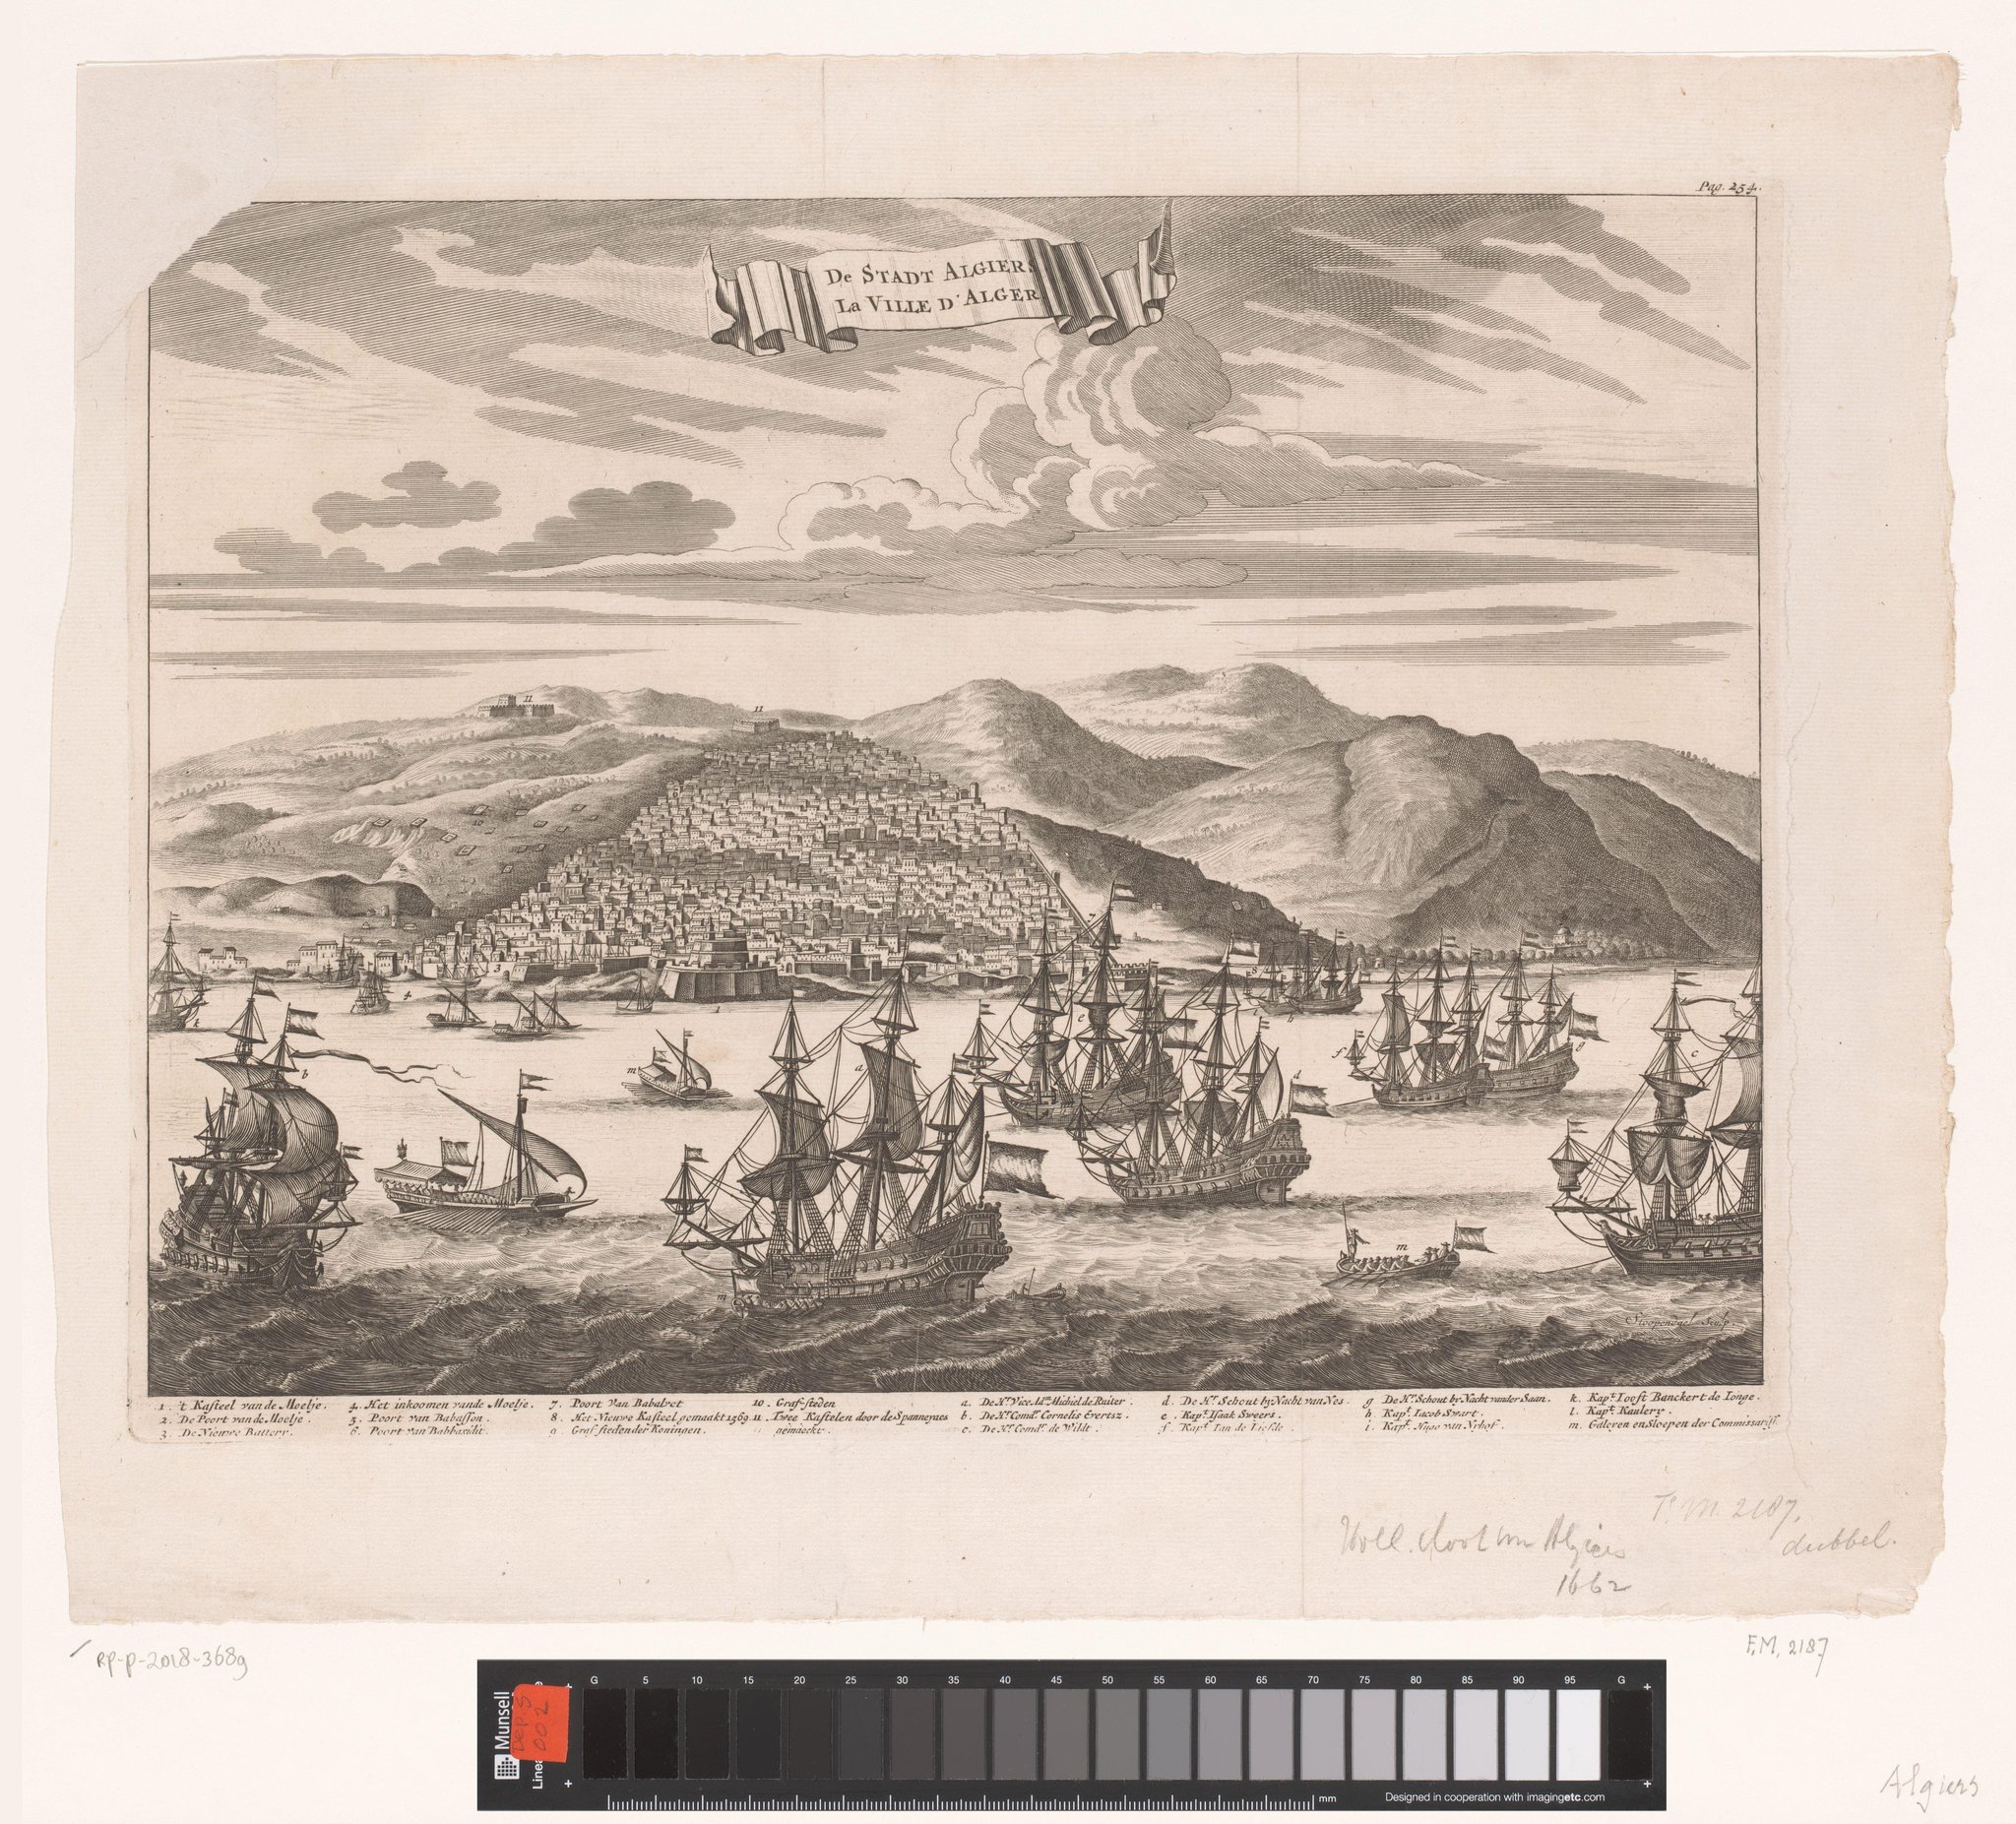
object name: print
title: De Stadt Algiers, La Ville d'Alger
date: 1687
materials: paper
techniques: engraving, etching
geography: amsterdam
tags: flushing, michiel adriaenszoon de ruyter, city-view, and landscape with man-made constructions, ships (in general) - cc - more than one ship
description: Gezicht op Algiers met de Staatse vloot onder admiraal Michiel Adriaenszoon de Ruyter voor anker liggend bij de stad ten tijde van de vredesonderhandelingen, 16 november 1662. Gemerkt rechtsboven: Pag. 254. In het onderschrift de legenda 1-11 en a-m.